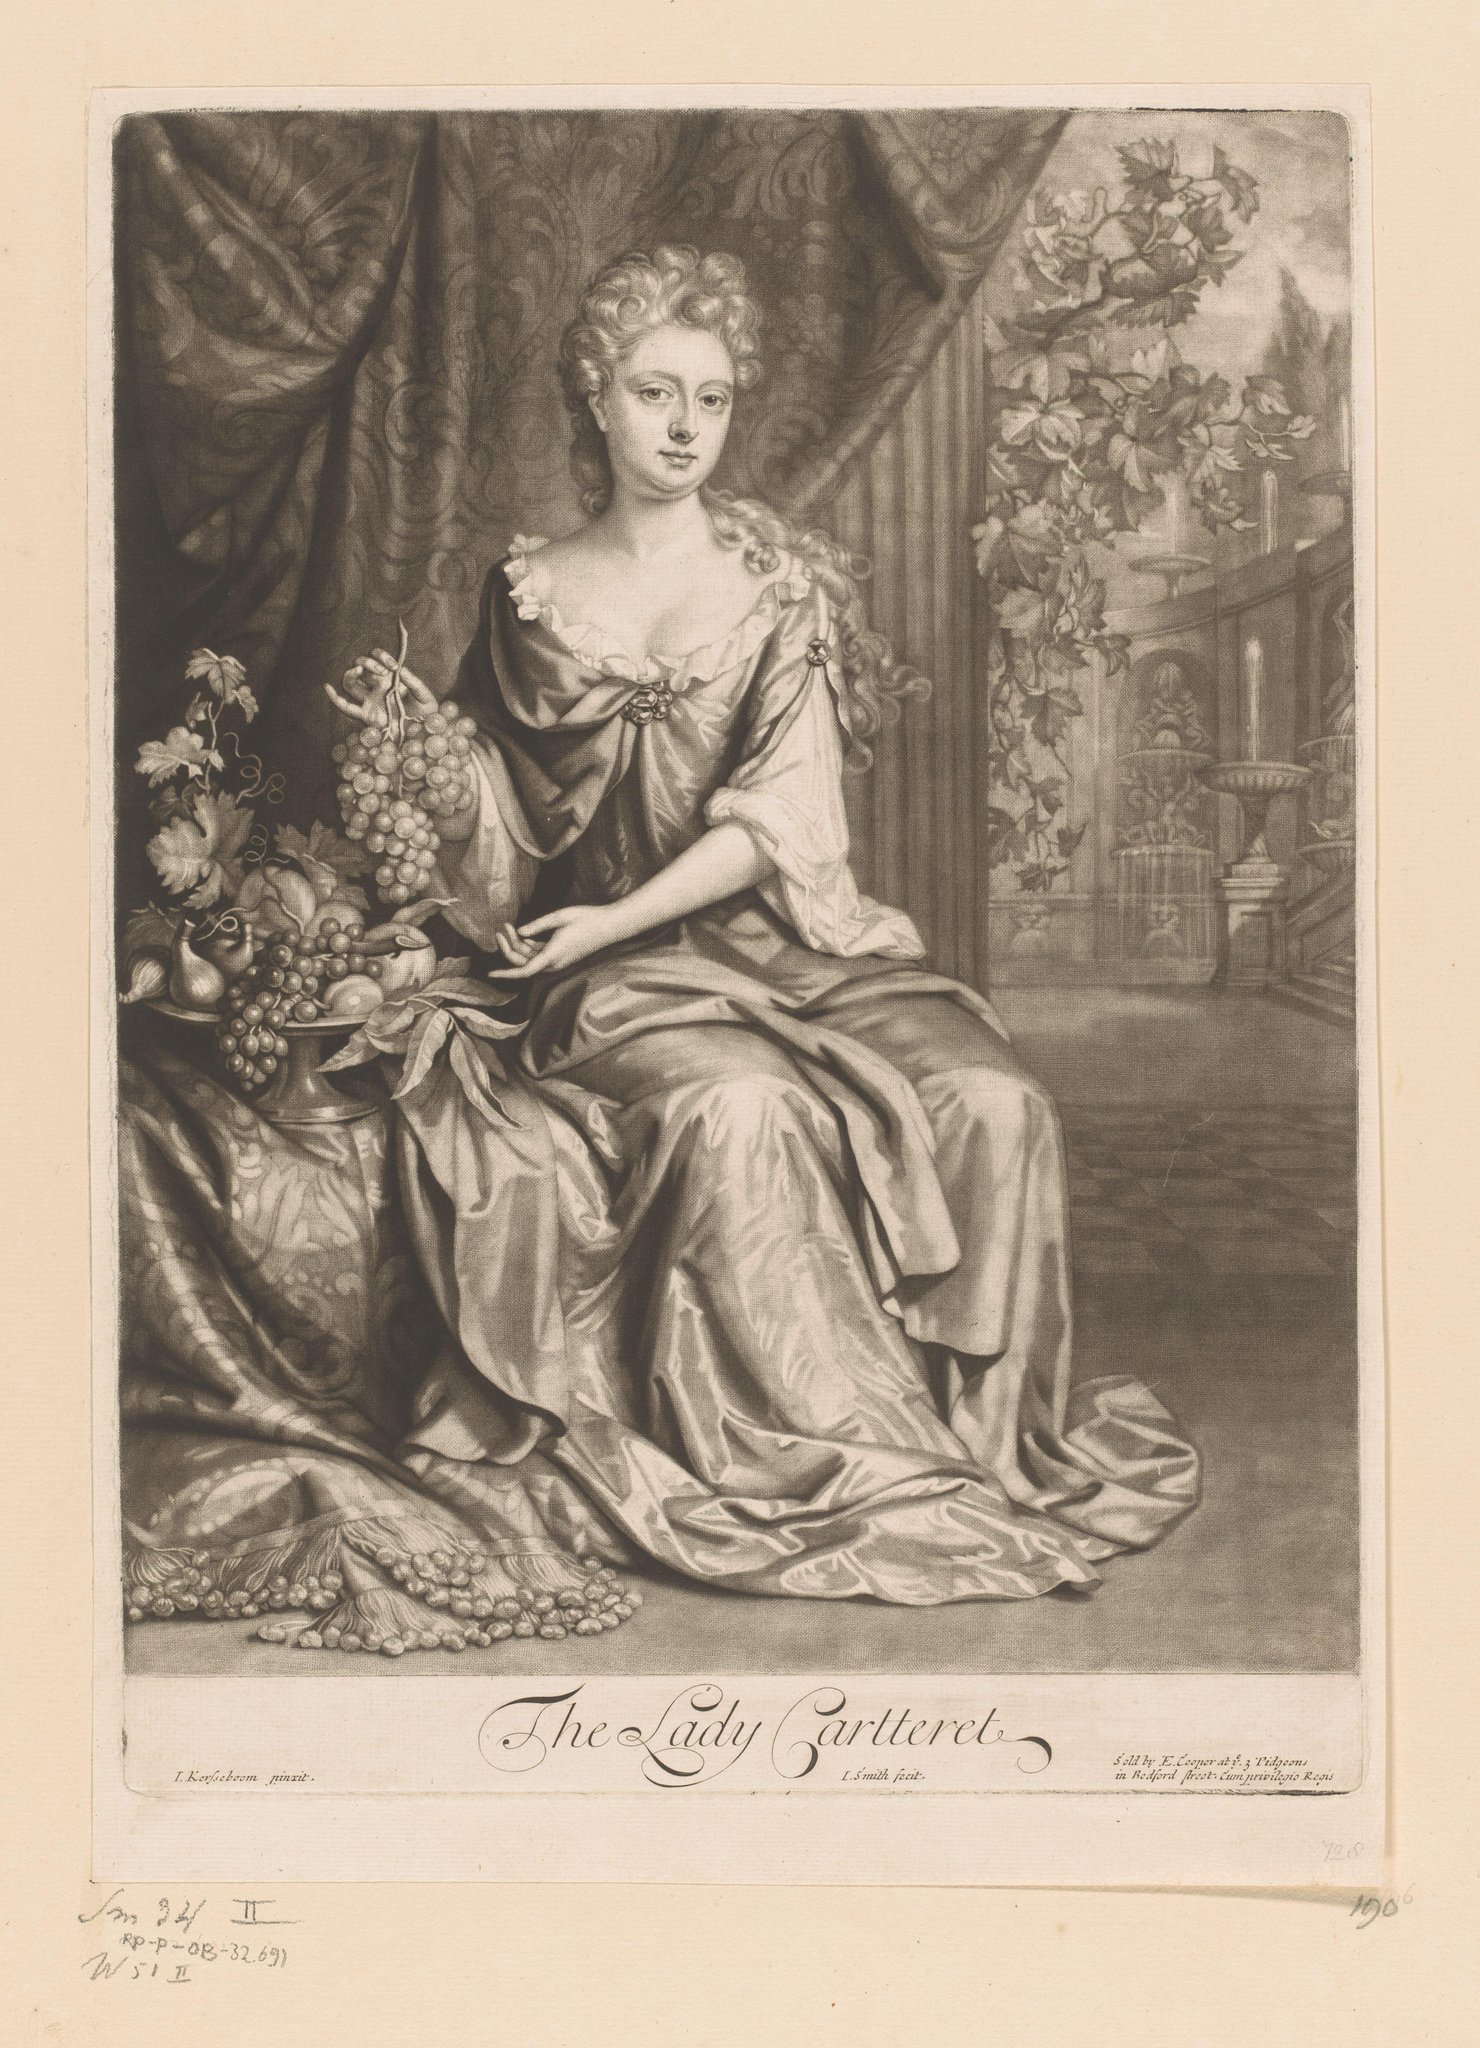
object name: print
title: Portret van Grace Carteret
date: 1686-1725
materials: paper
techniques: mezzotint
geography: london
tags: historical persons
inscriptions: collector's mark: Lugt 240